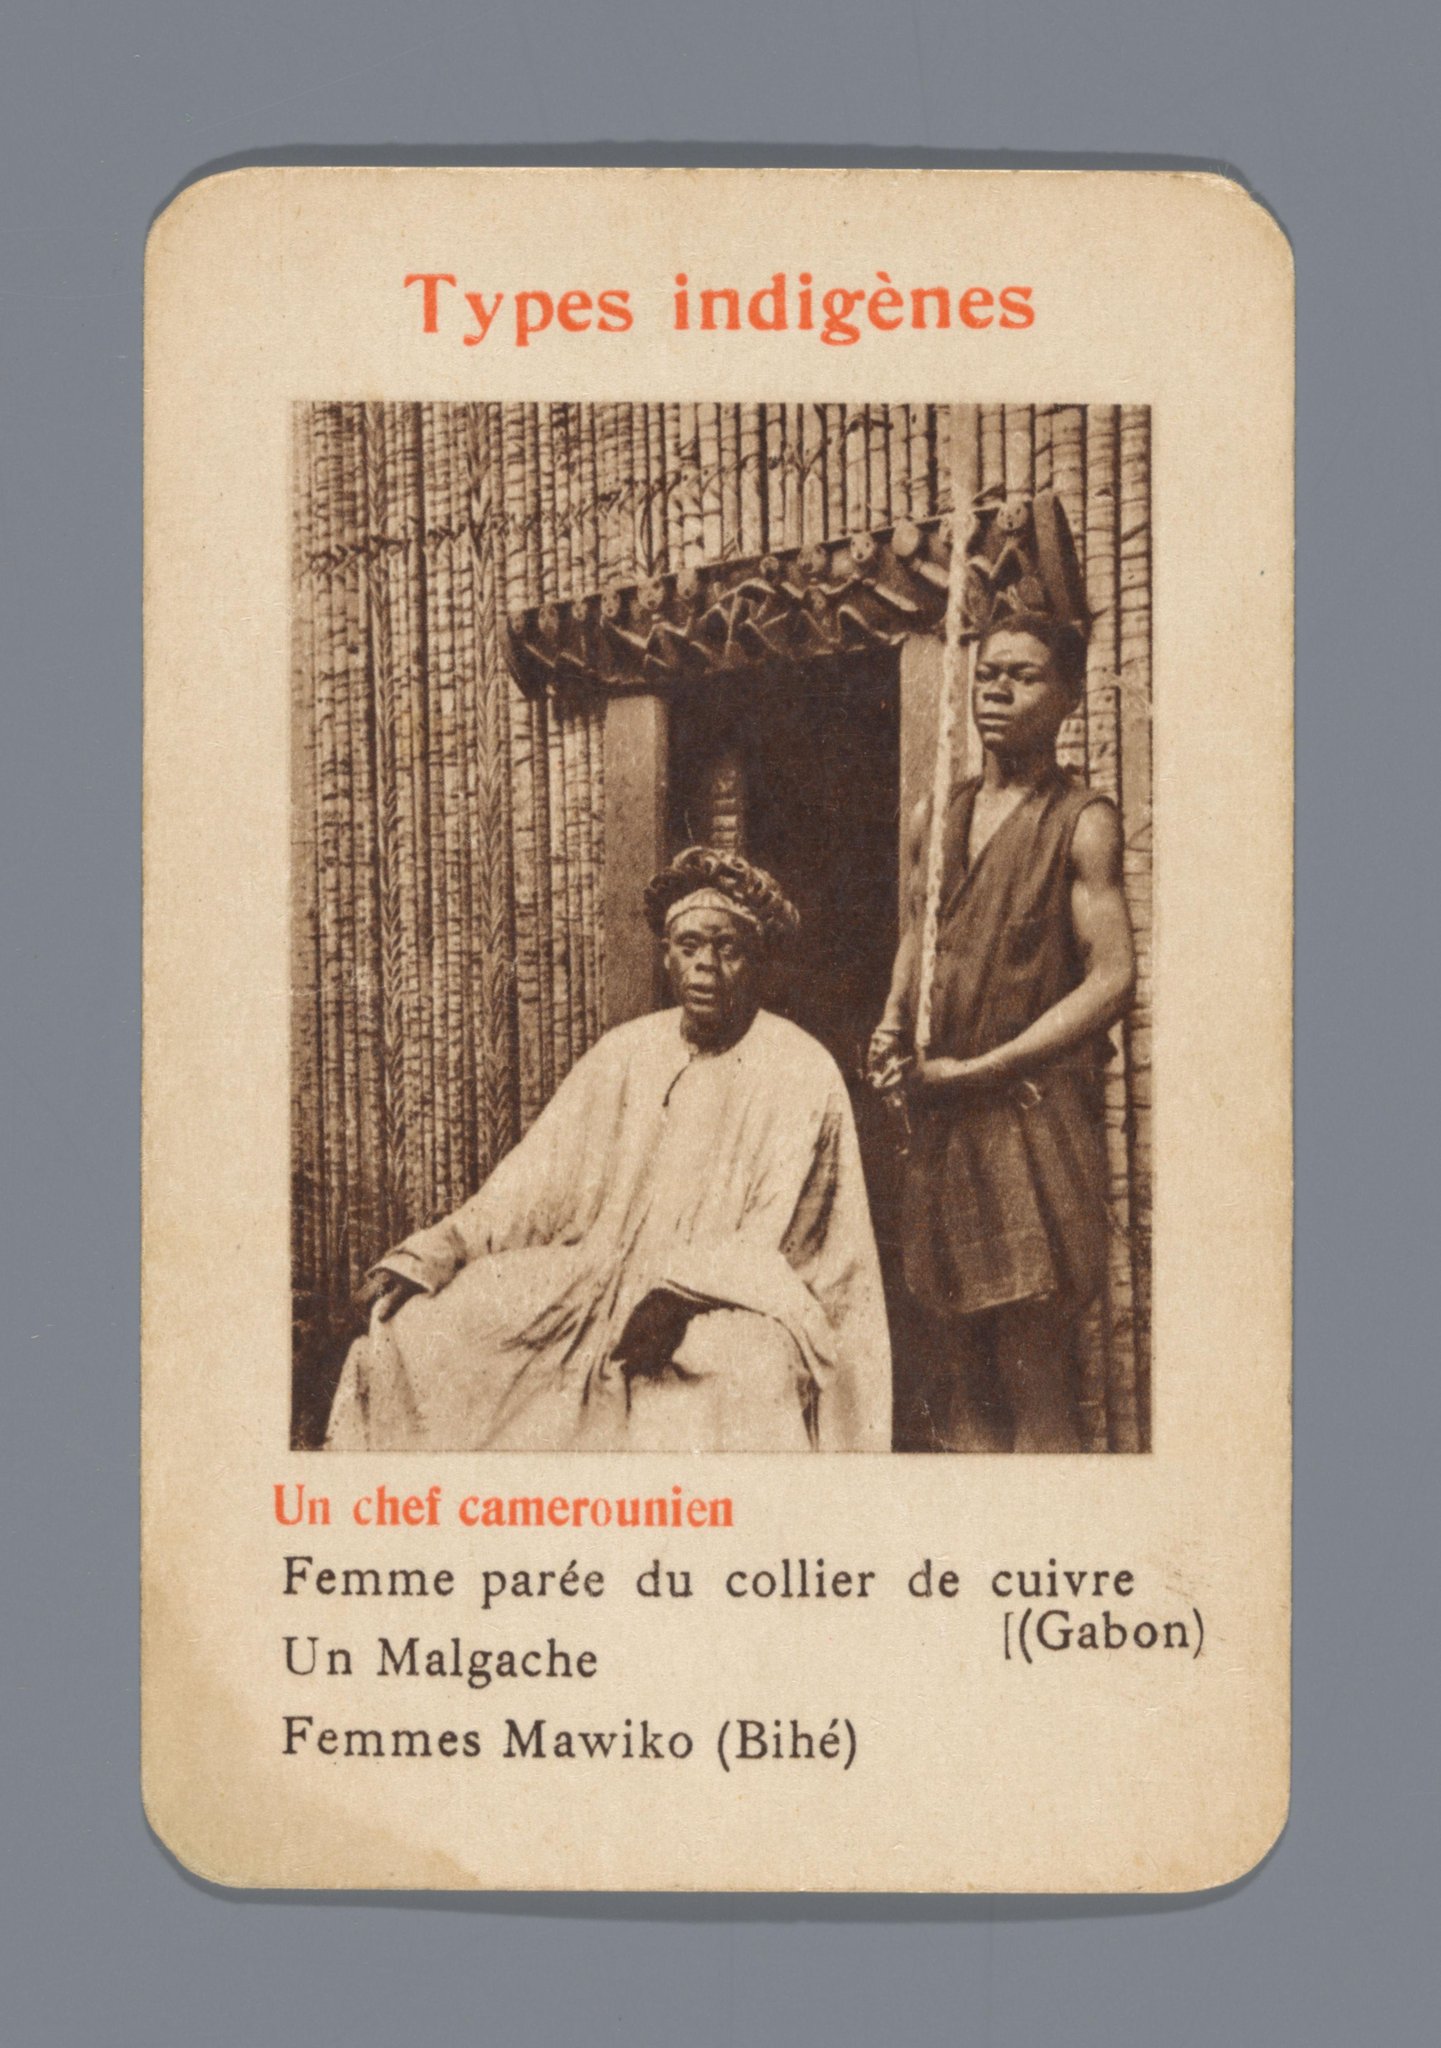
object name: card game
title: Portret van een onbekende lokale leider in Kameroen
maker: Anonymous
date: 1900-1920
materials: cardboard, paper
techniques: rotogravure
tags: africans, historical persons, card games